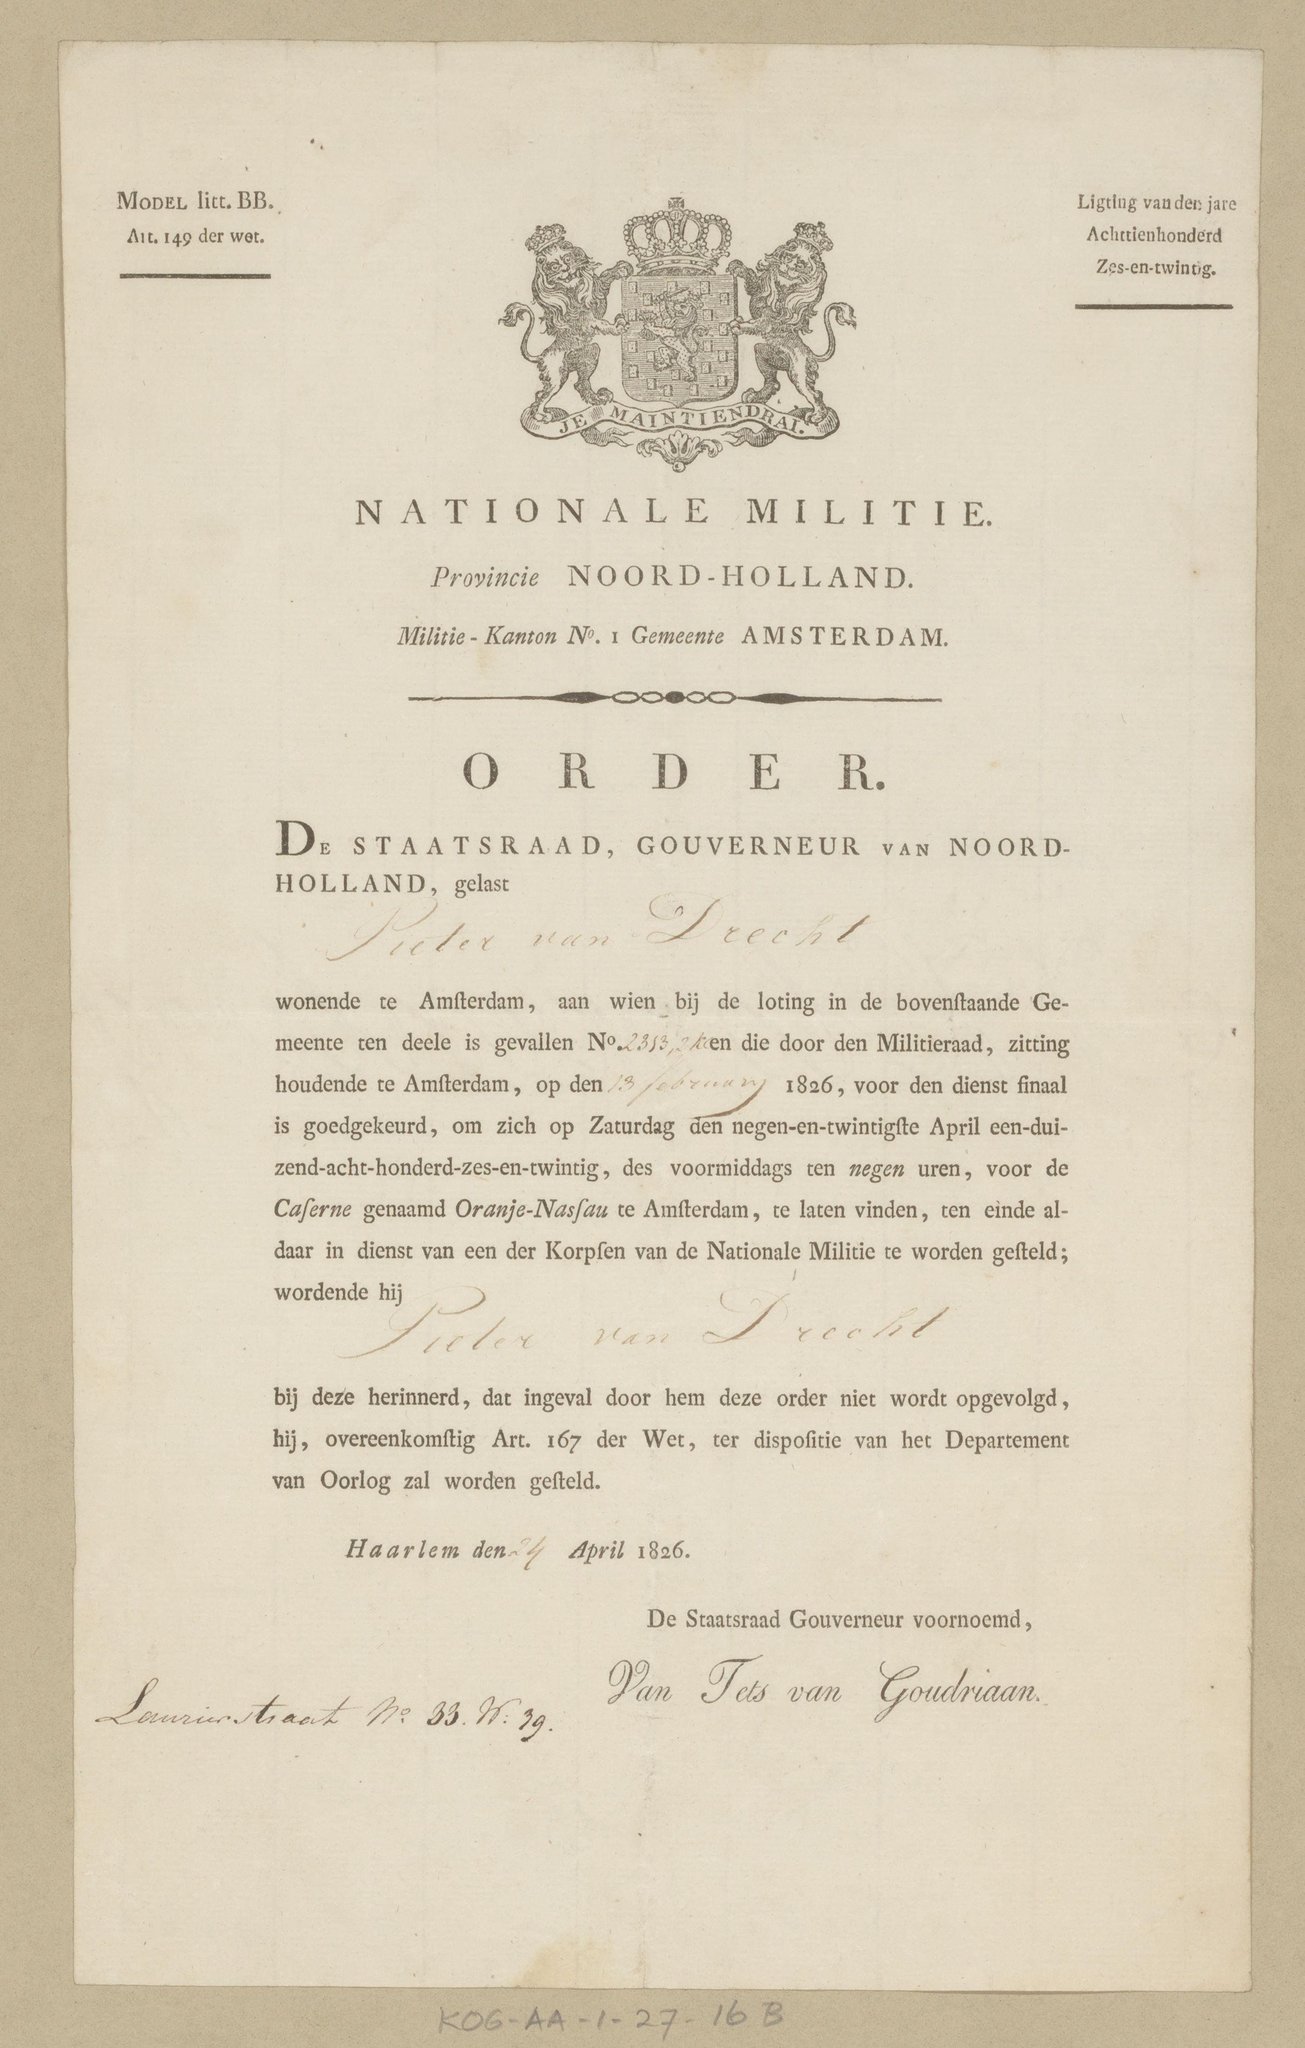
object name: text sheet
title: Order aan Pieter van Drecht om zich aan de Oranje-Nassau Kazerne te Amsterdam te melden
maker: Anonymous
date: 1826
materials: paper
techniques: letterpress printing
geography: netherlands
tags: the hague, politician, communication (military)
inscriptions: collector's mark: Lugt 1641b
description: Onderwerpsrubriek binnen de Atlas Amsterdam: Landmacht: Gebouwen / Herinneringen aan officieren, stadssoldaten / Nationale militie / (diverse korpsen) / Padvinders / Parade.